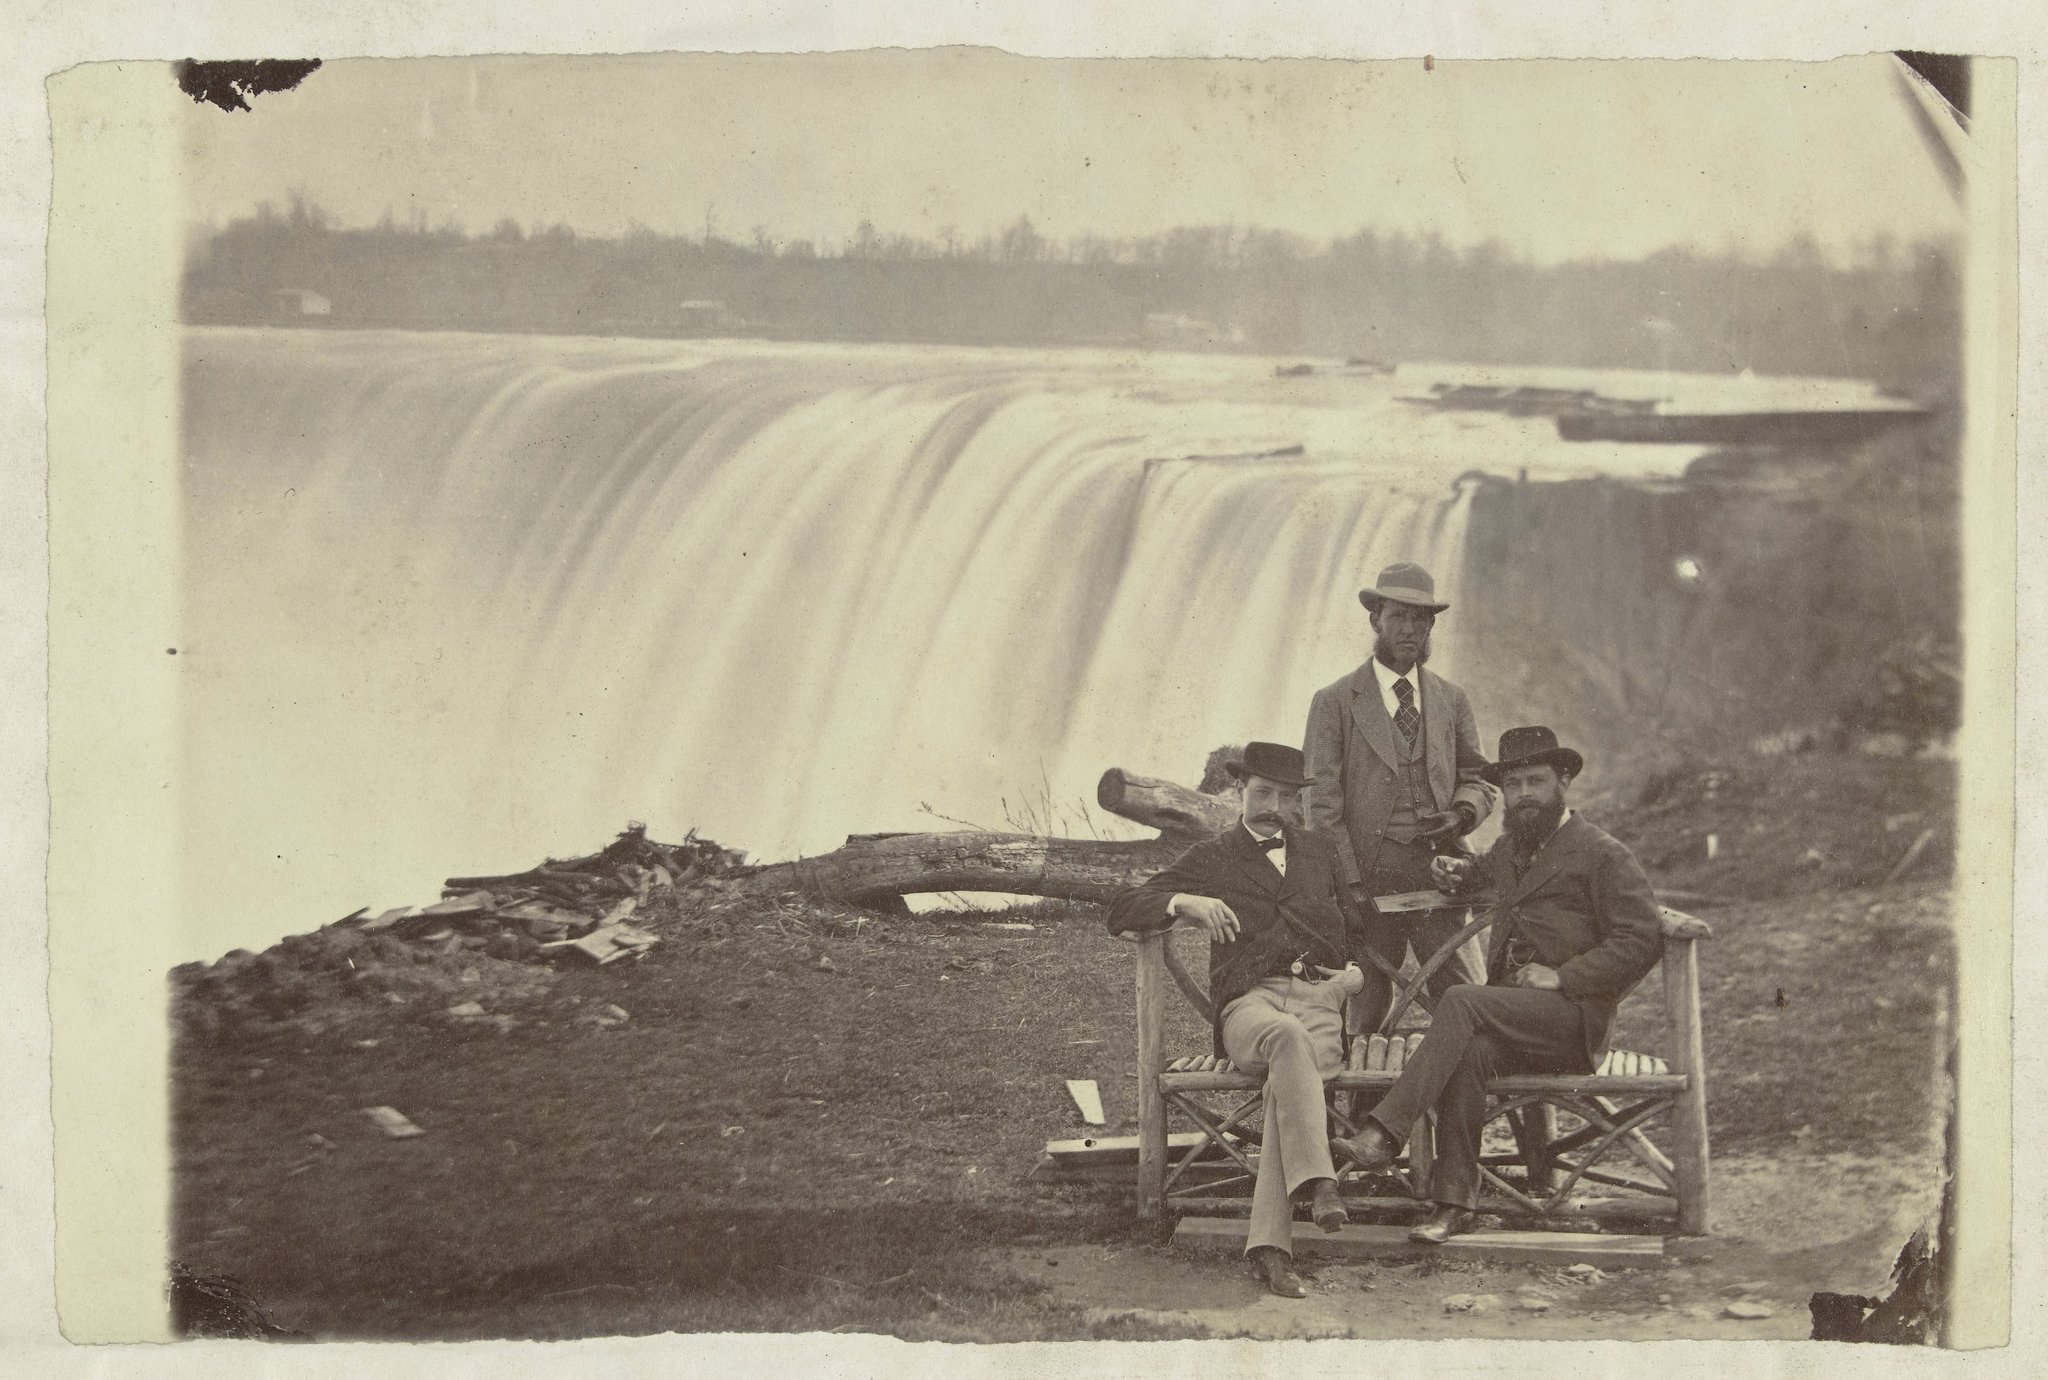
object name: photograph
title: Groepsportret van drie mannen op een bank bij de Niagara Falls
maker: Anonymous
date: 1879-1890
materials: paper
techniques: albumen print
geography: united states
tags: waterfall, anonymous historical persons portrayed in a group, in a group-portrait